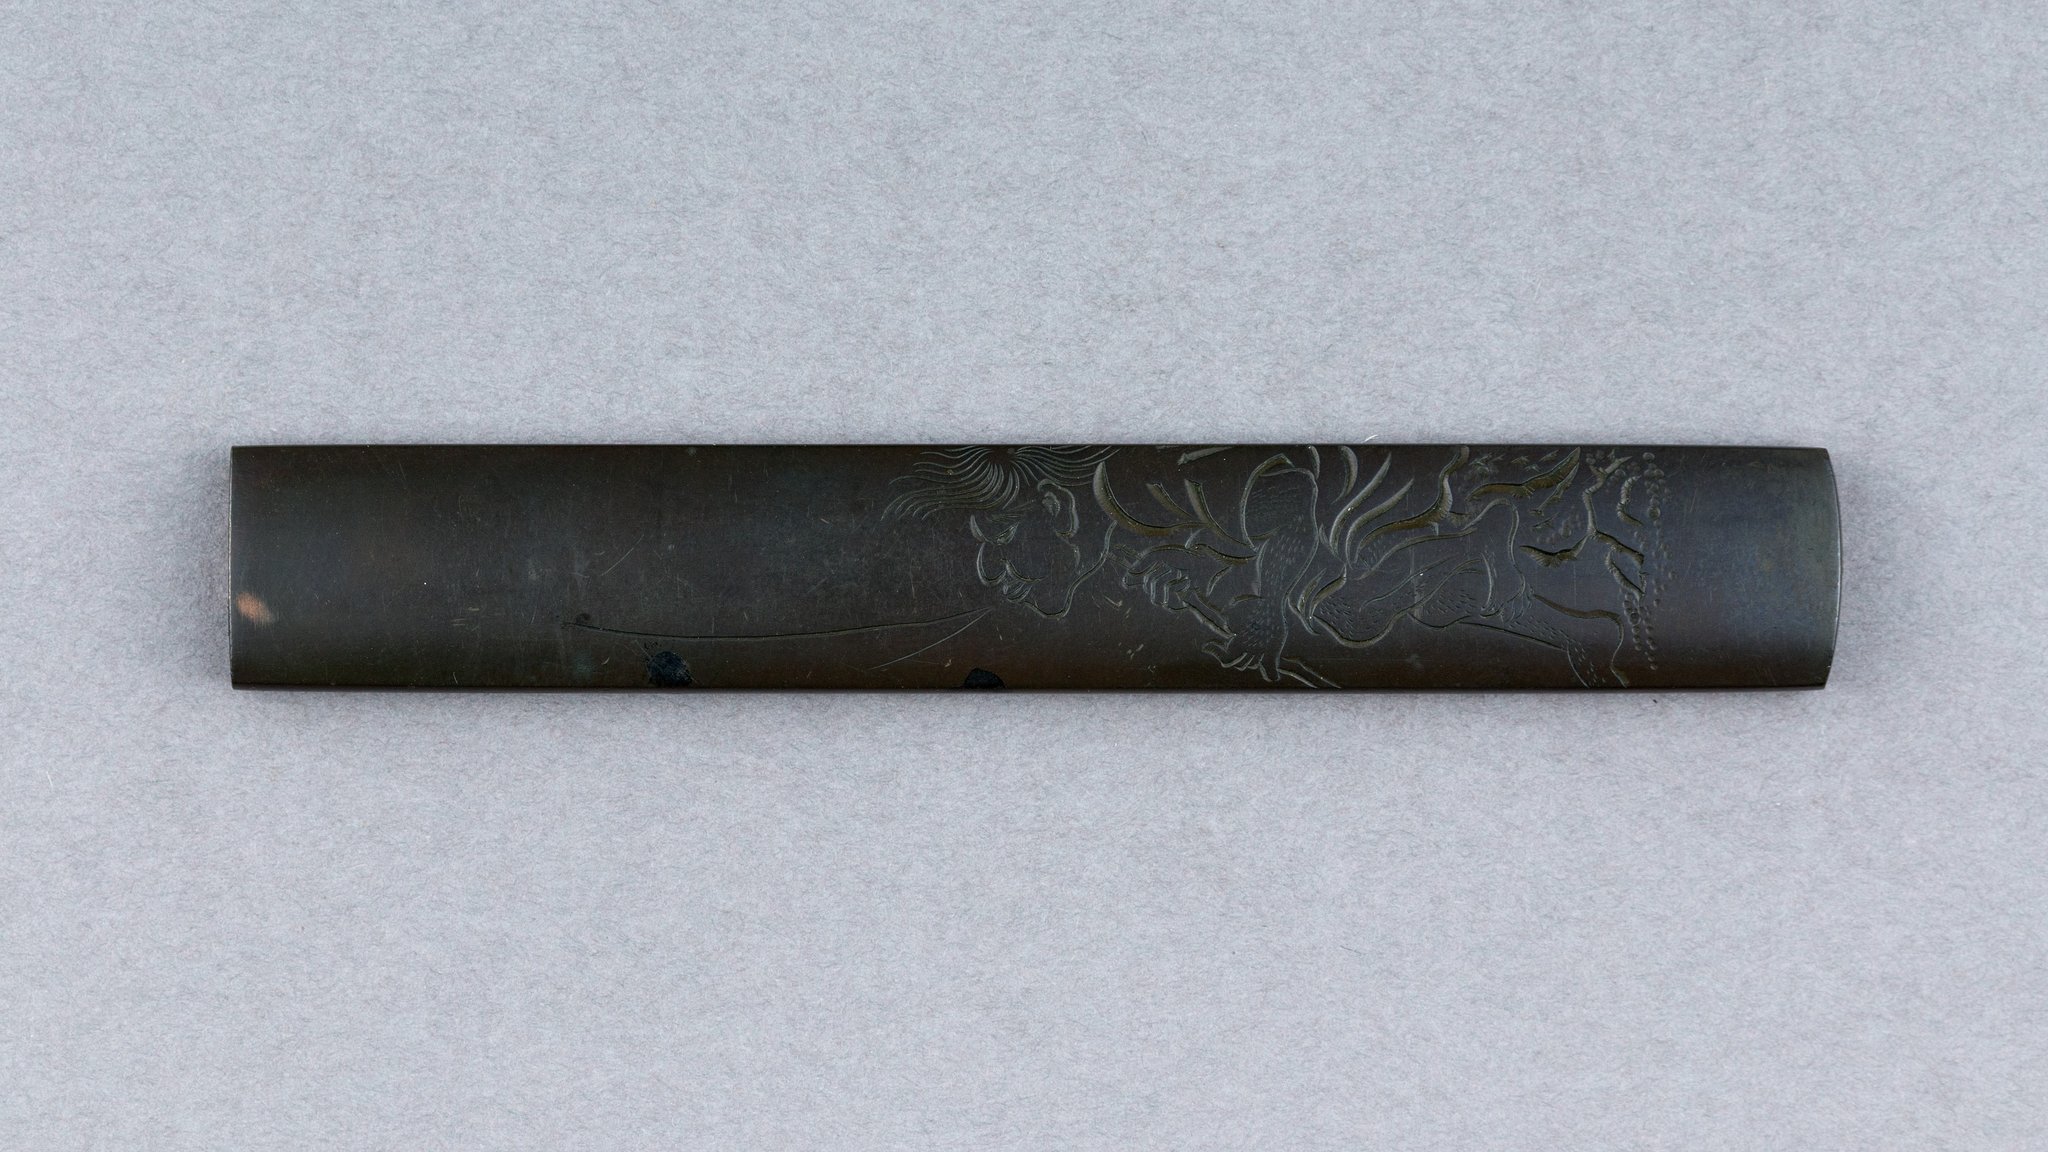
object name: knife handle kozuka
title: Knife Handle (Kozuka)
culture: japanese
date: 1615-1868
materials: copper, silver alloy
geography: japan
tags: men